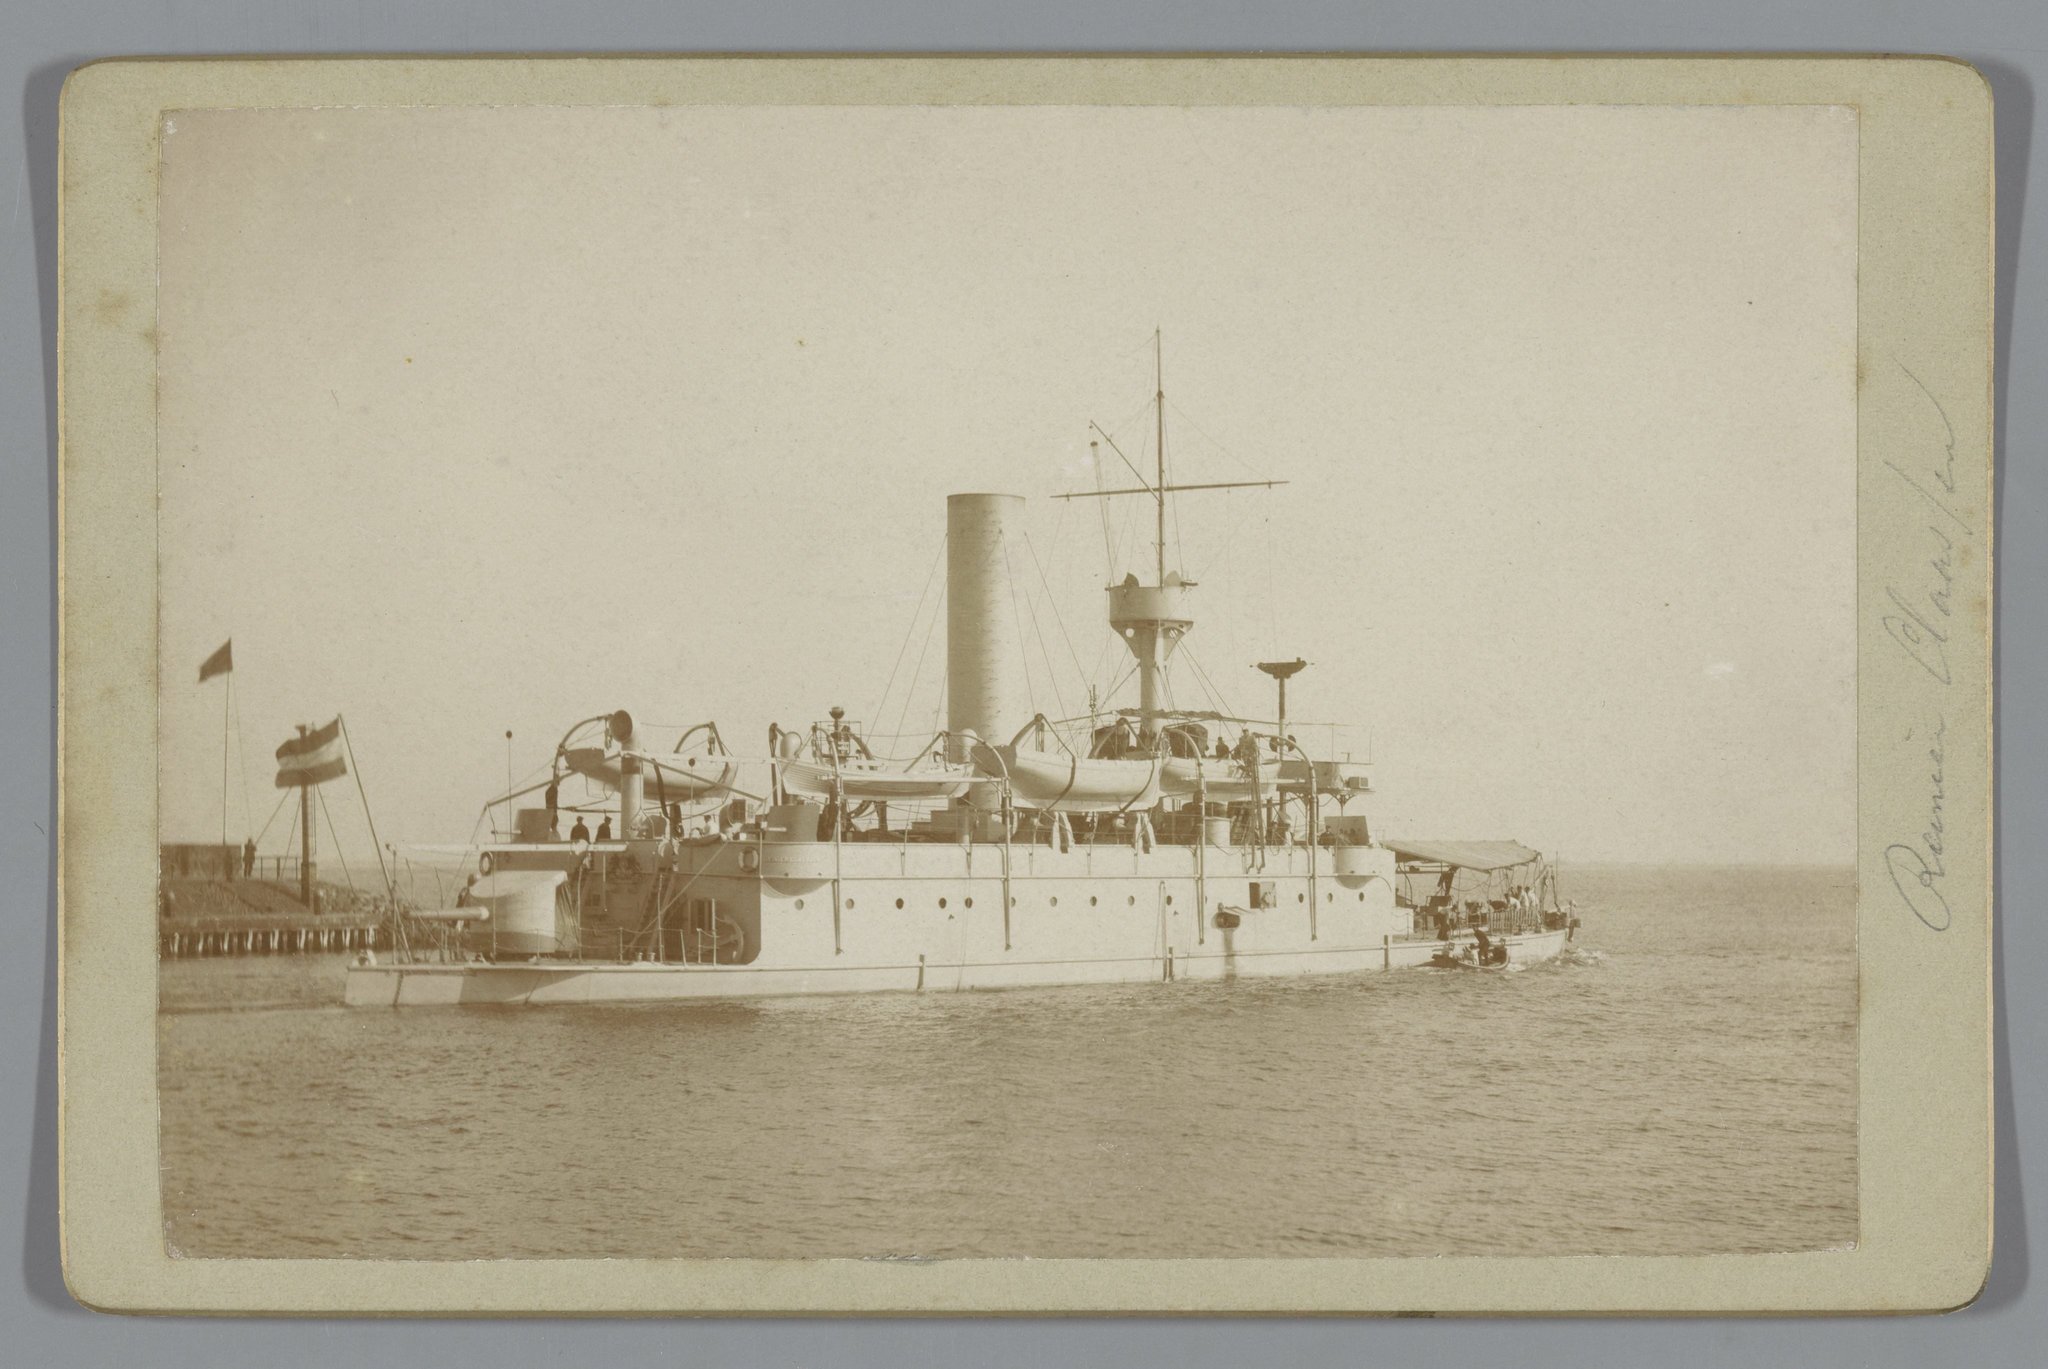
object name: cabinet photograph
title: Monitor Reinier Claeszen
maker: Anonymous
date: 1894-1910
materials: paper, cardboard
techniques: collodion silver print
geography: den helder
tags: navy, steamship, motorship, den helder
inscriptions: collector's mark: ‘Vosmaer’, inscription: ‘Reinier Claeszen’